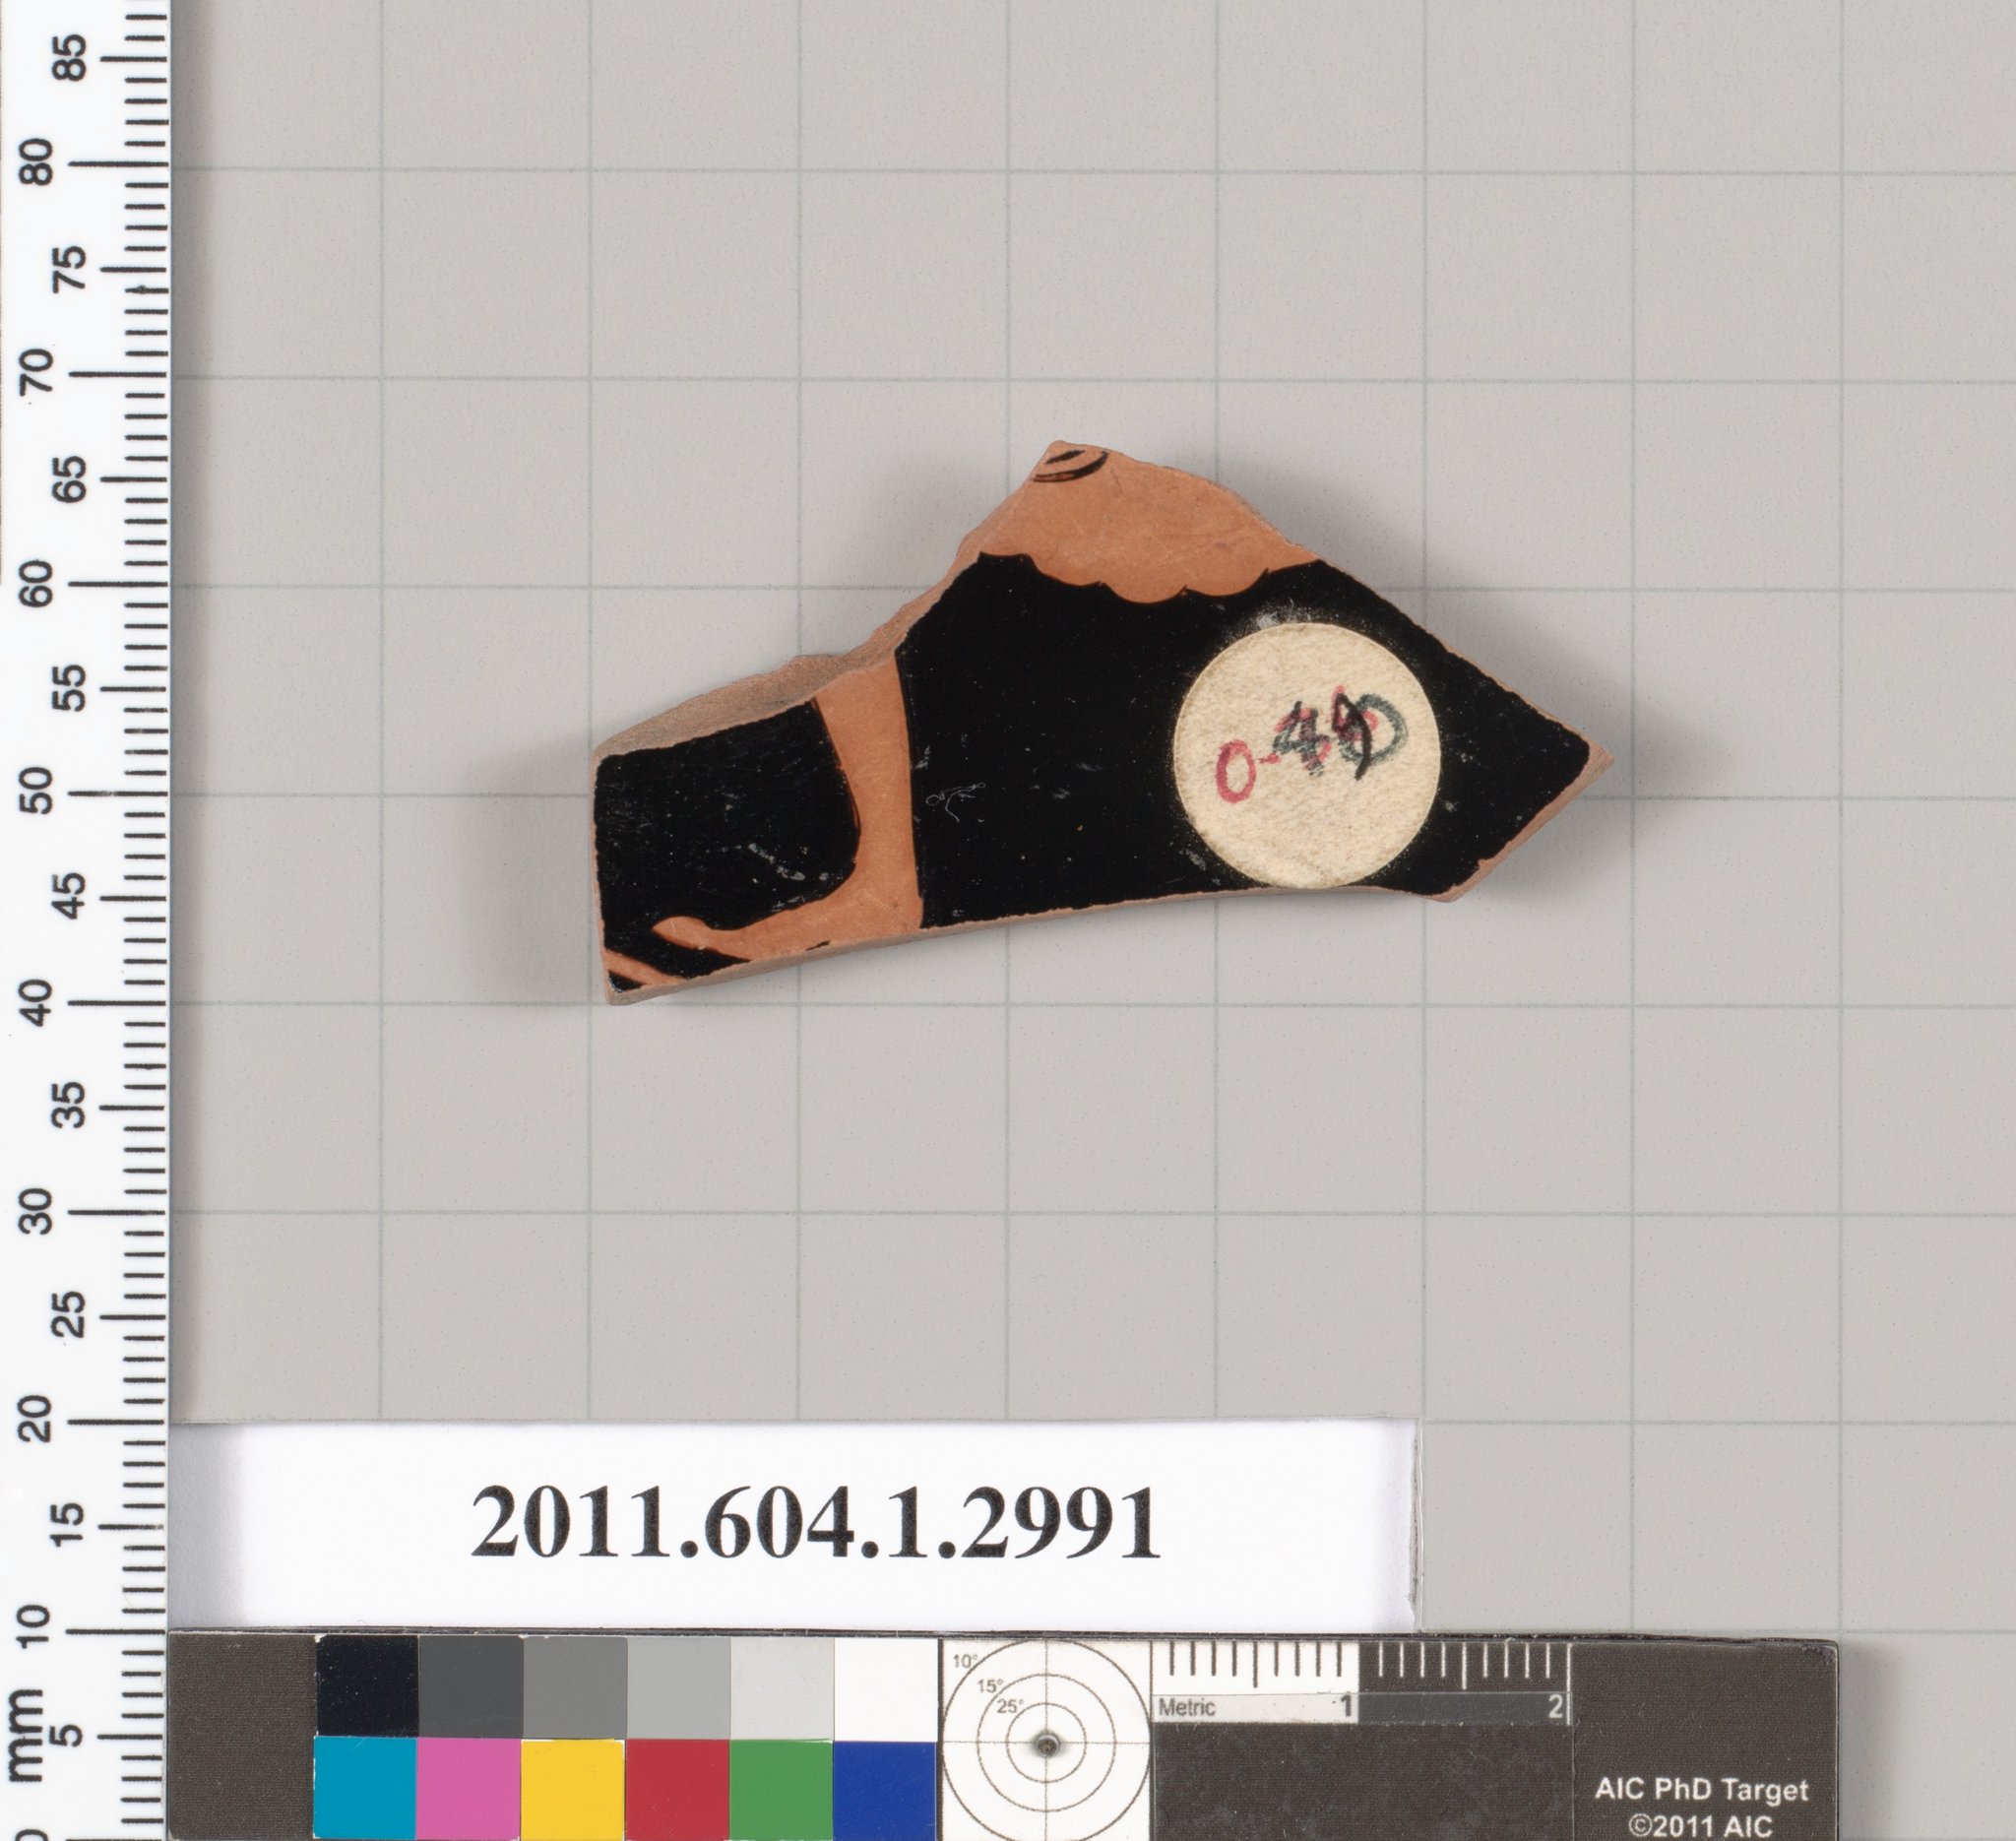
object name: kylix fragment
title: Terracotta fragment of a kylix (drinking cup)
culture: greek, attic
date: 500-490 BCE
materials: terracotta